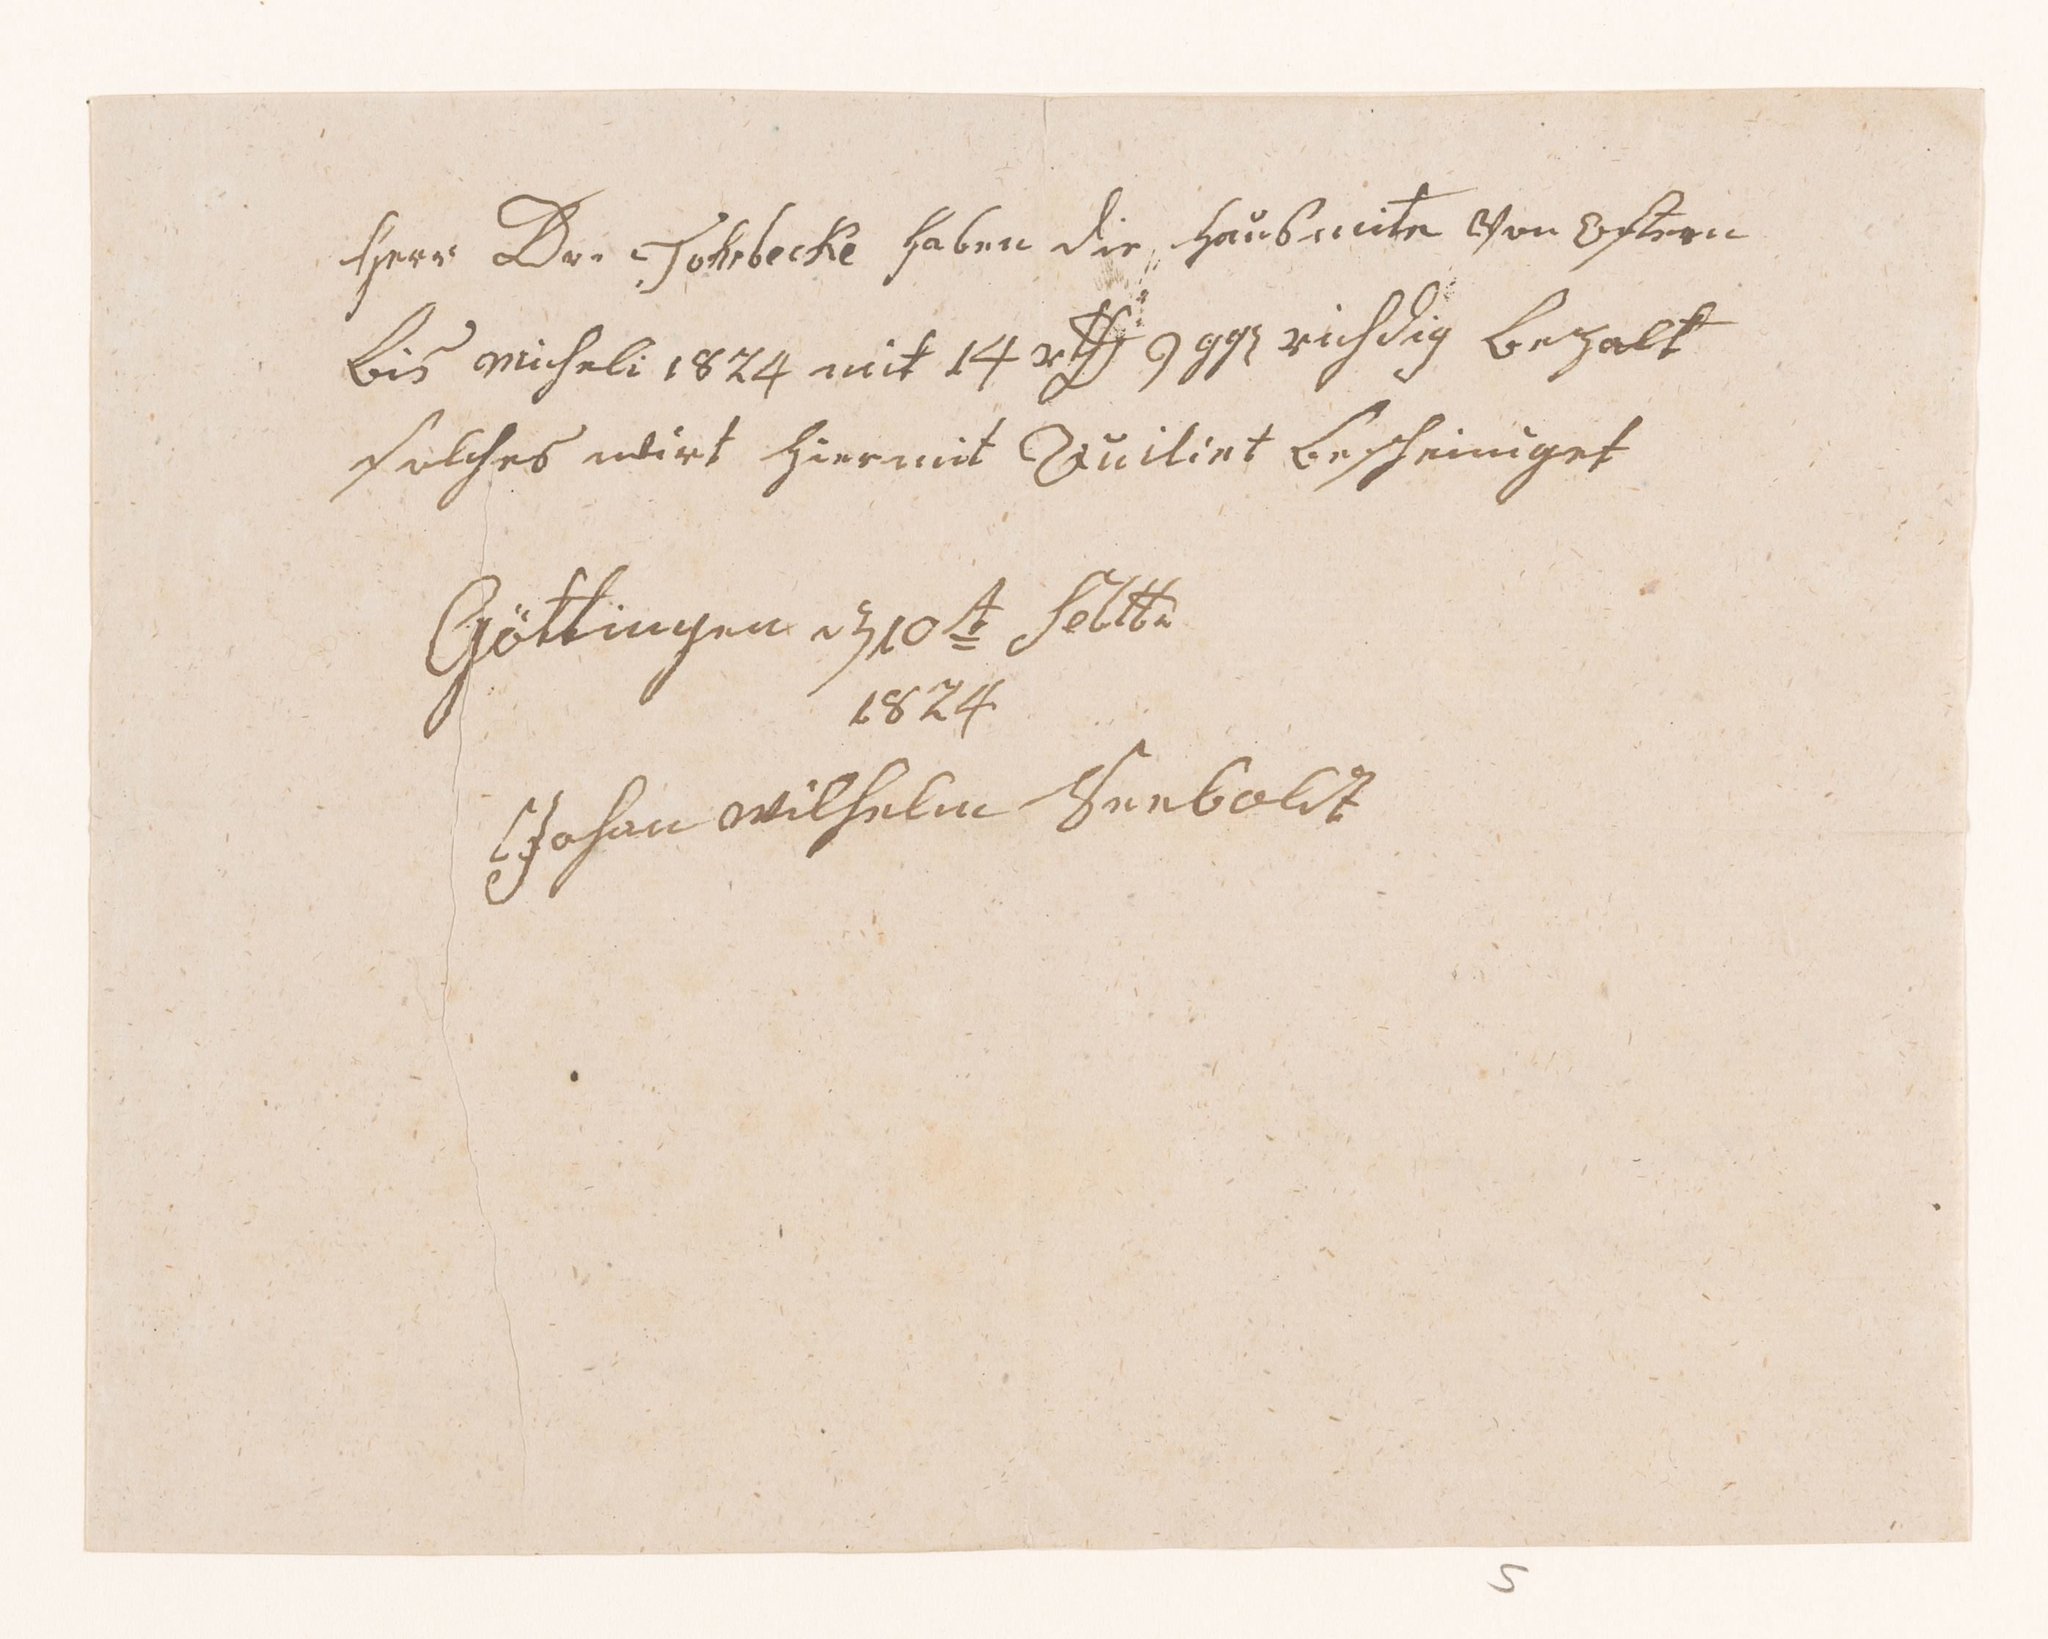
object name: document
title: Huishuurkwitantie van J.R. Thorbecke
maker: Anonymous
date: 1809-1824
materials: ink, paper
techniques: printing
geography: germany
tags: the hague, johan rudolf thorbecke, germany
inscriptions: date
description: Document van J.R. Thorbecke tijdens zijn verblijf in Duitsland (1820-1824).